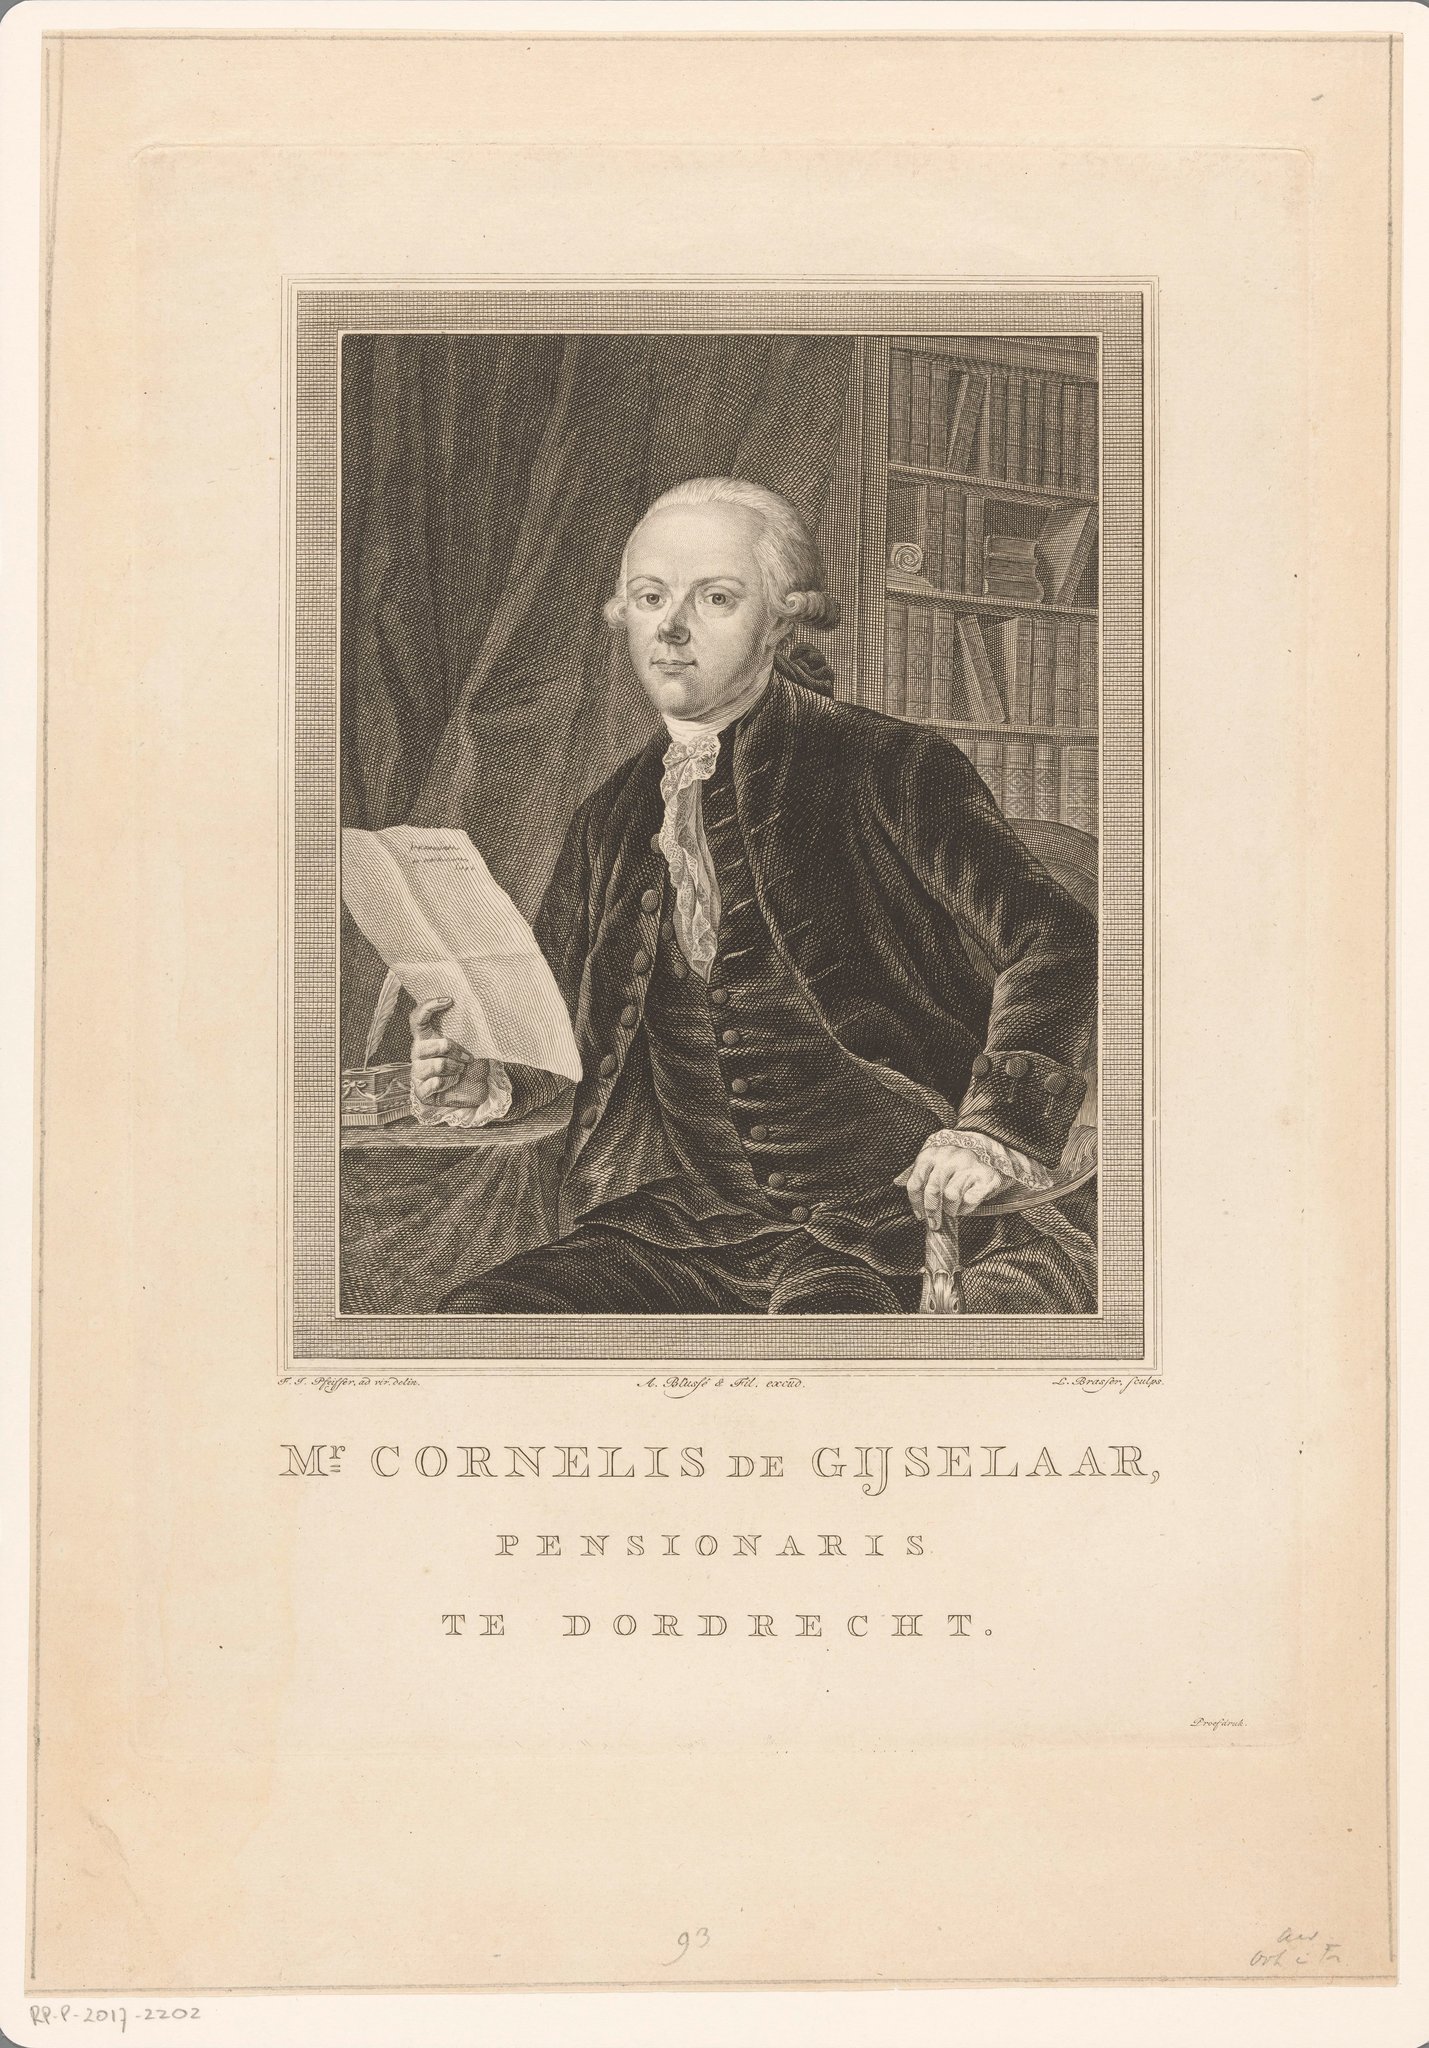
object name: print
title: Portret van Cornelis de Gijselaar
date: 1779-1793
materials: paper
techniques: engraving, etching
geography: dordrecht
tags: leiden, historical persons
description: Portret van Cornelis de Gijselaar, patriot en pensionaris van Dordrecht in 1779-1787, zittend met een brief in zijn hand.